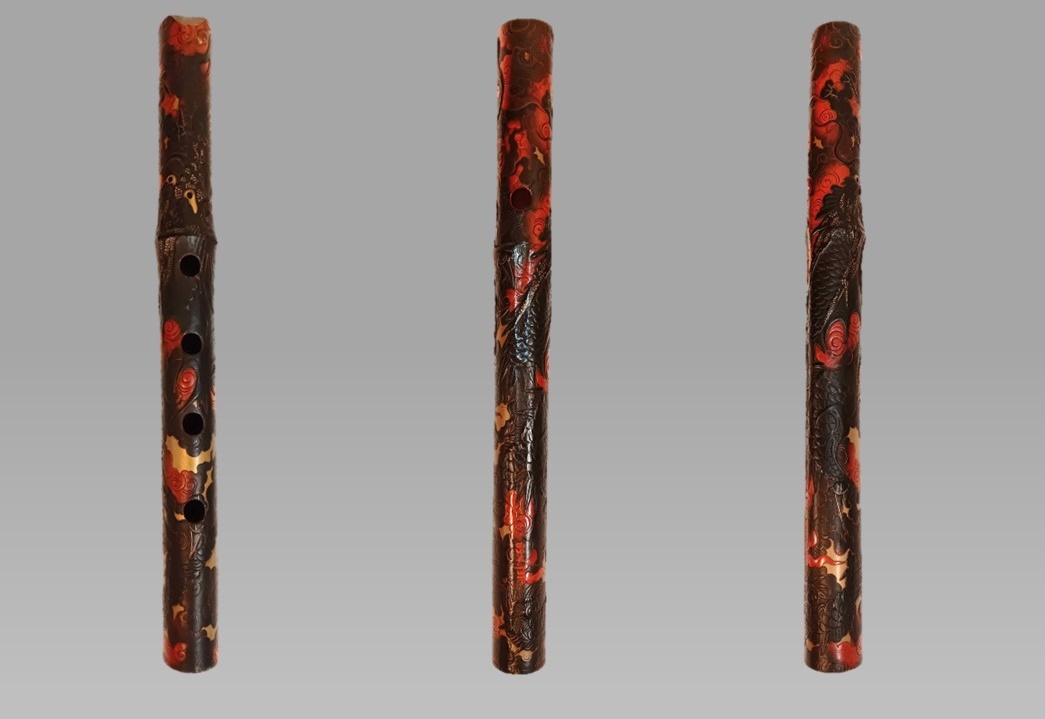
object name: hitoyogiri 一節切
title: Hitoyogiri (一節切)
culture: japanese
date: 1867-1900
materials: bamboo, lacquer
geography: japan